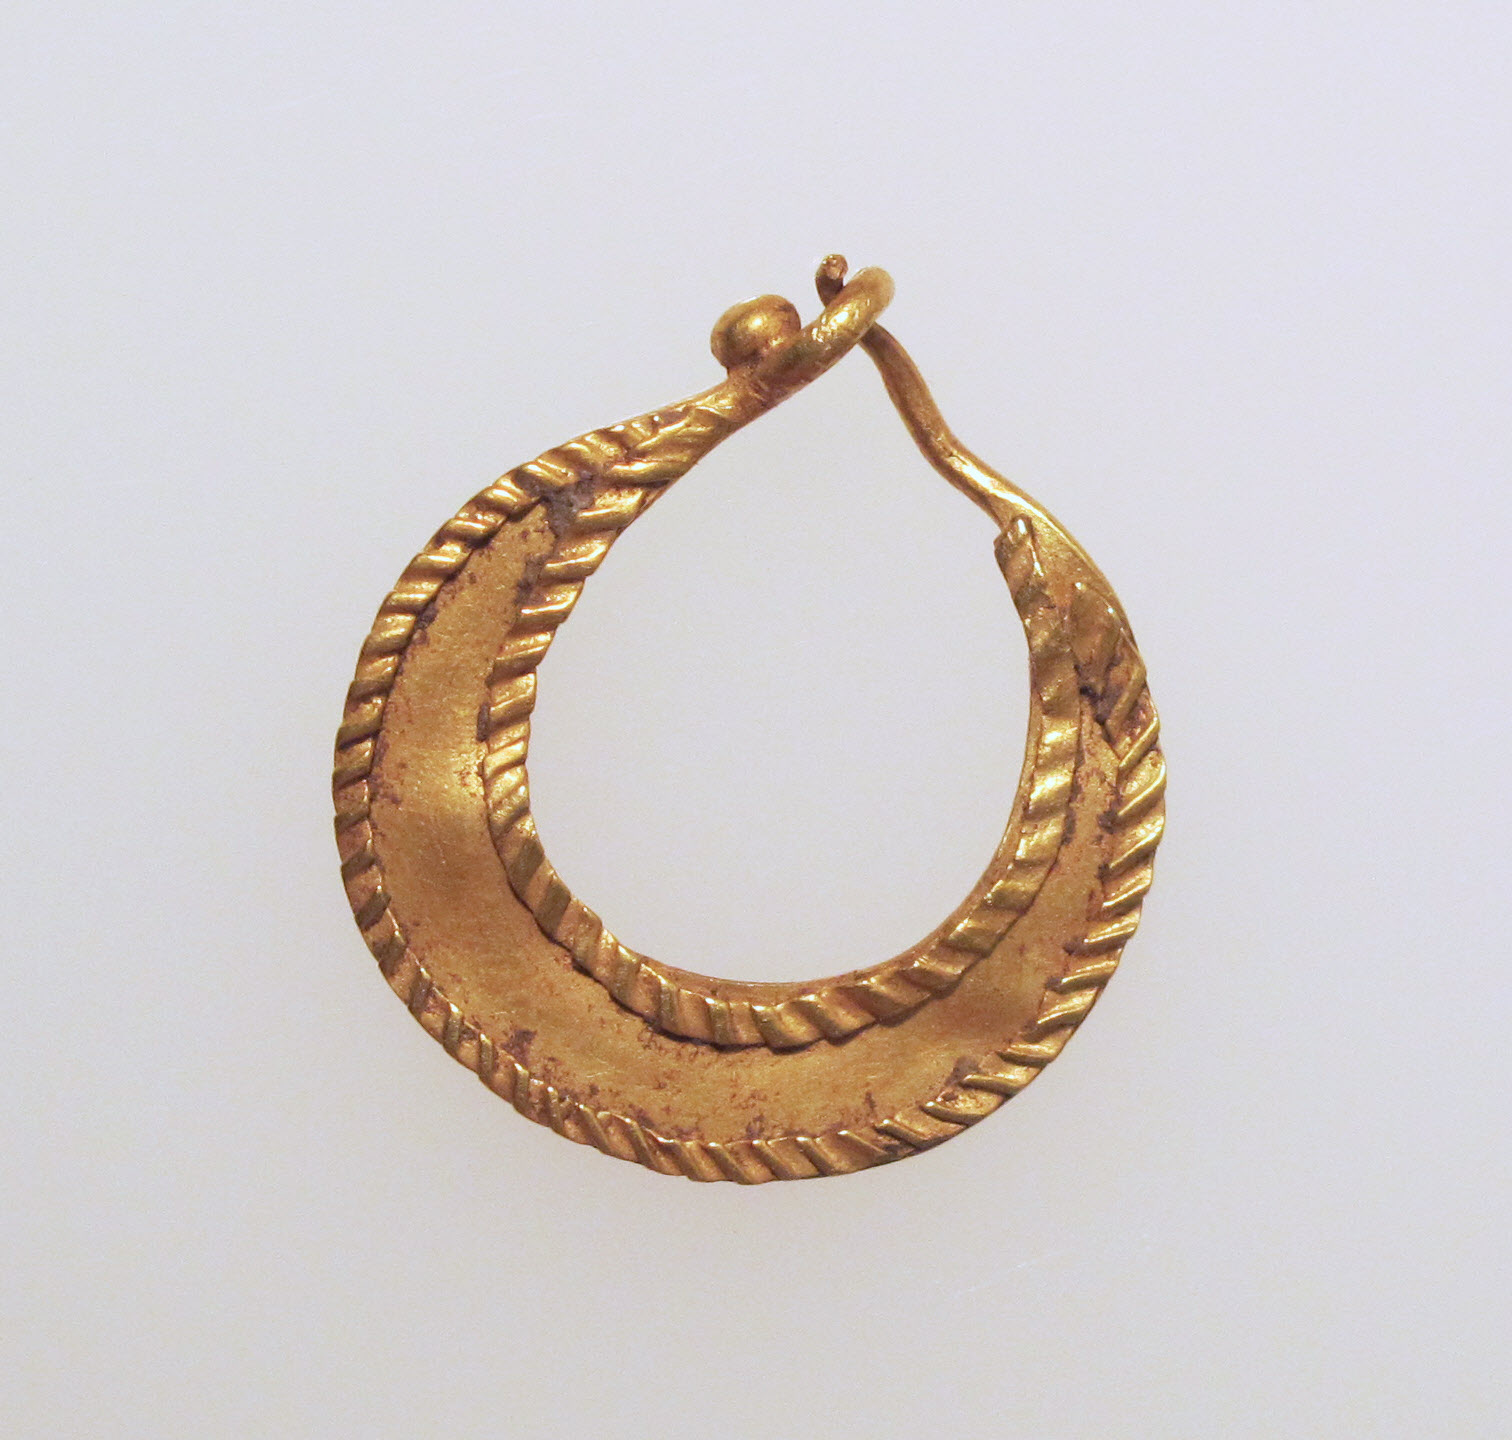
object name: earring, crescent shaped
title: Earring, crescent-shaped, decorated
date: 7000 BCE-330 CE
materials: gold